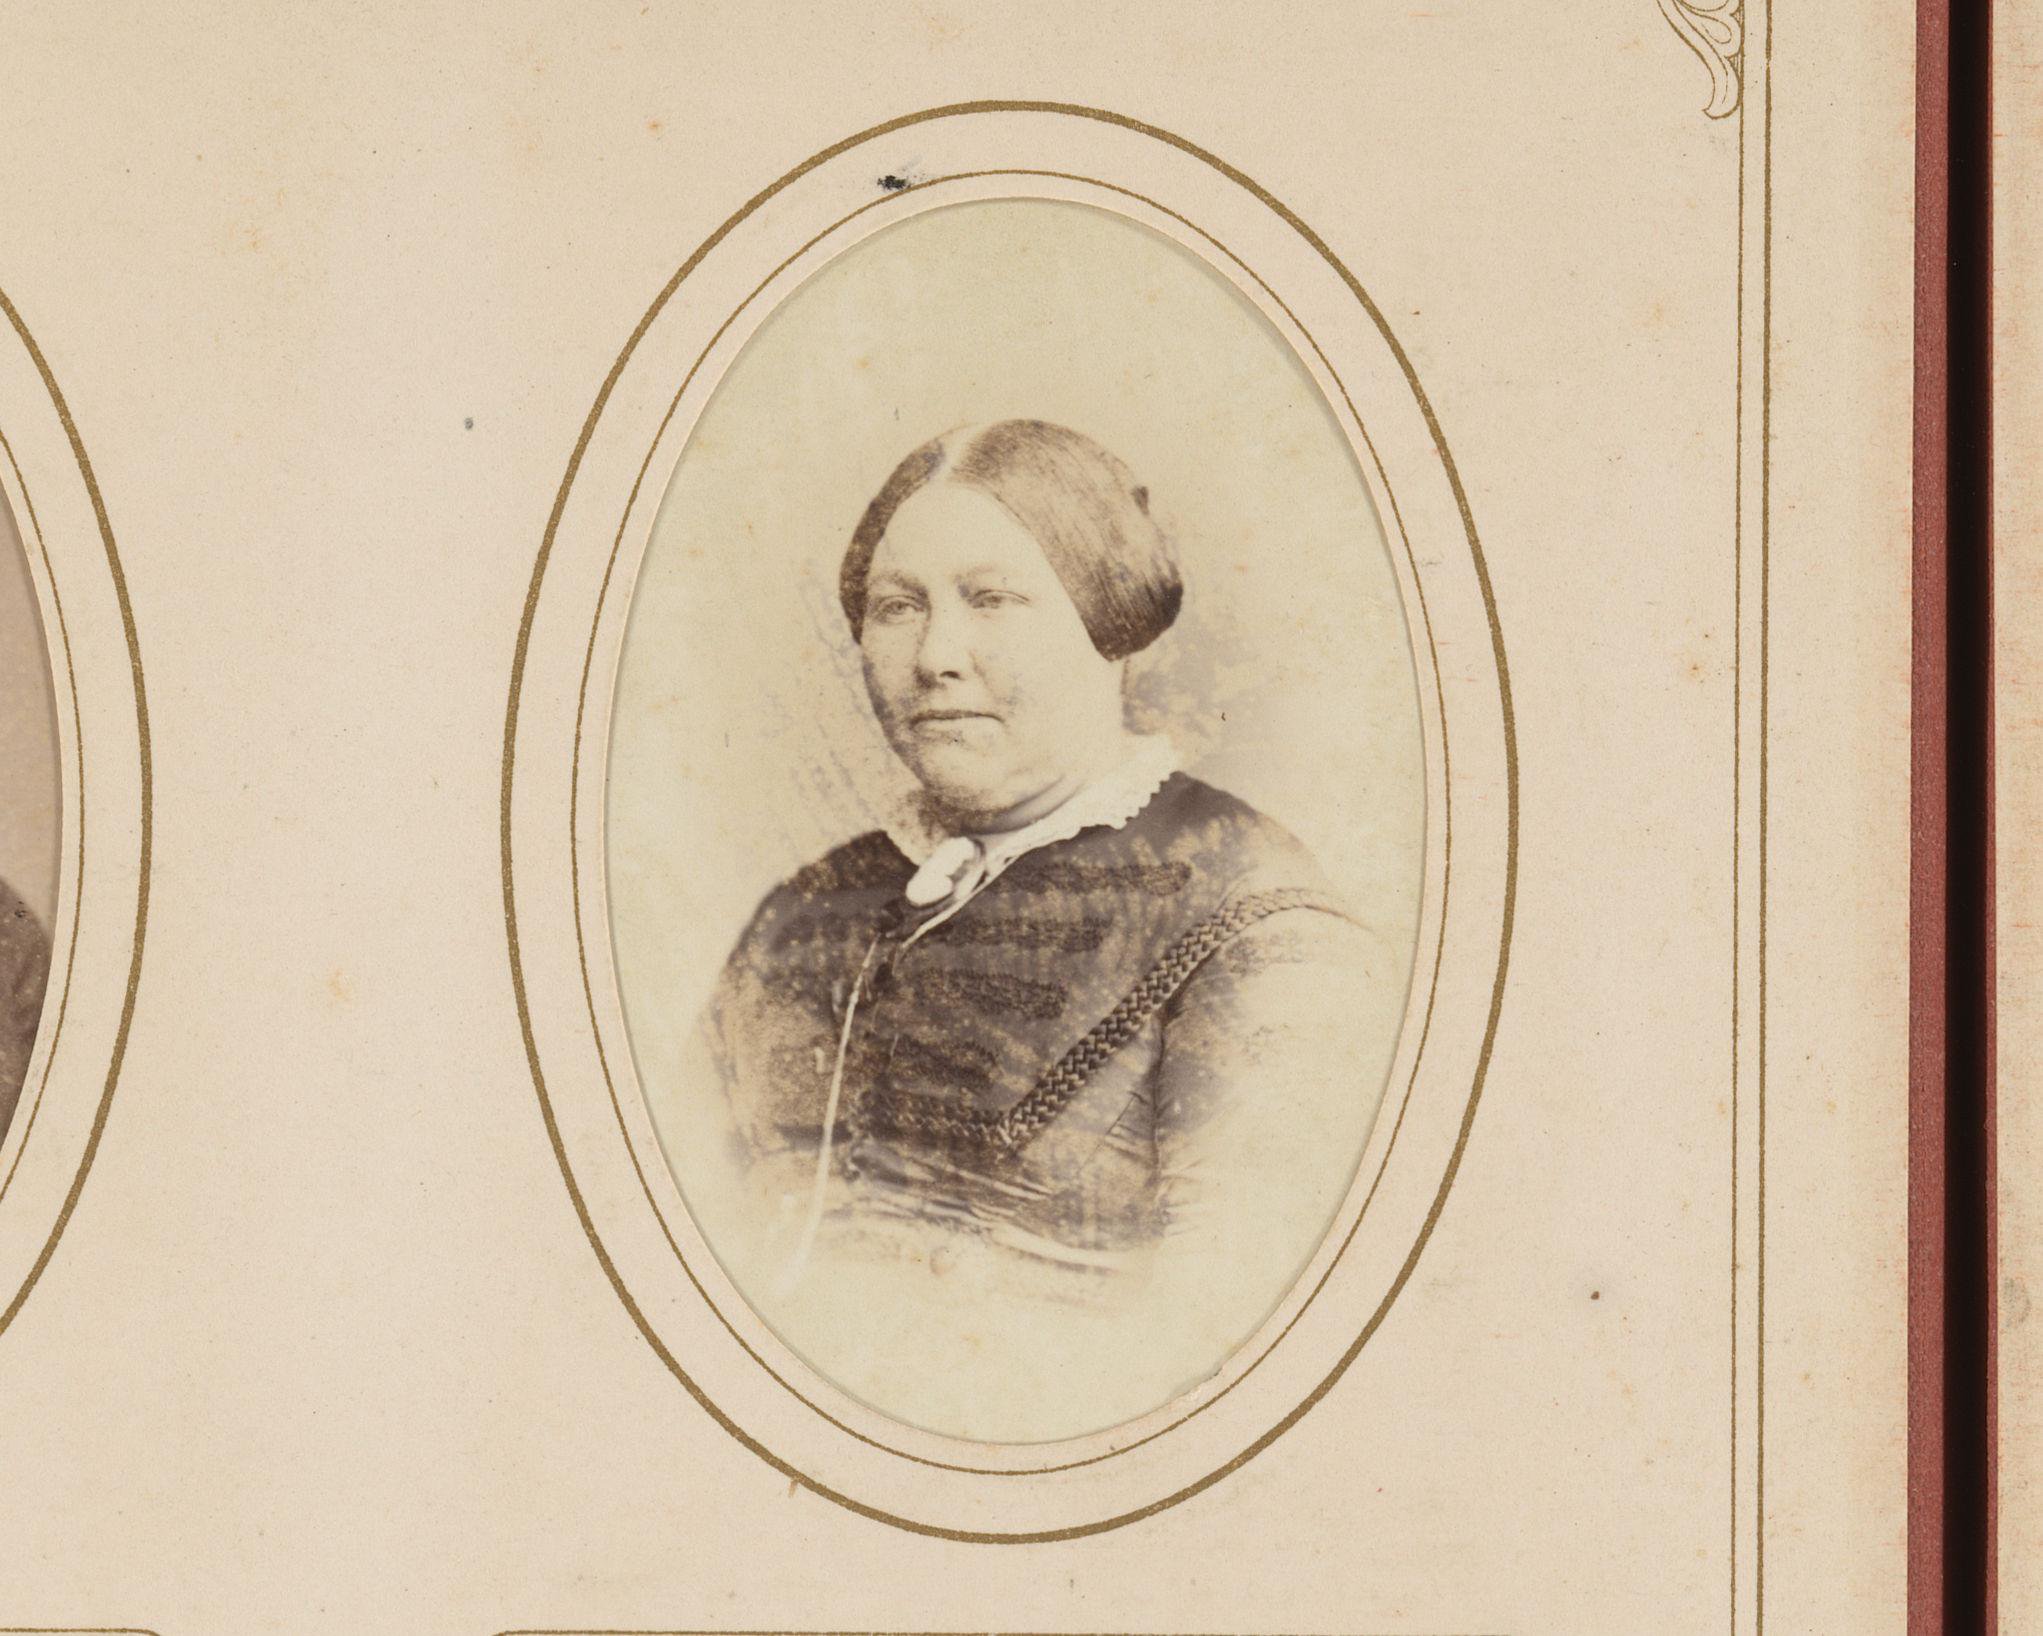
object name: photograph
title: Portret van een vrouw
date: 1807-1871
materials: cardboard, photographic support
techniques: albumen print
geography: netherlands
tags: historical persons - bb - woman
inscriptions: inscription: ‘Photogr. Atelier/ van/ Wegner & Mottu/ Kalverstraat D. 26./ AMSTERDAM./ Leijdschestraatweg buiten Catharijnen/ UTRECHT./ STEENDRUKKERY & PHOTOLITHOGRAPHIE/ Keyzersgracht H. H. 479./ AMSTERDAM./ Het cliché wordt voor verdere bestellingen bewaard.’, annotation: ‘Juli '71’